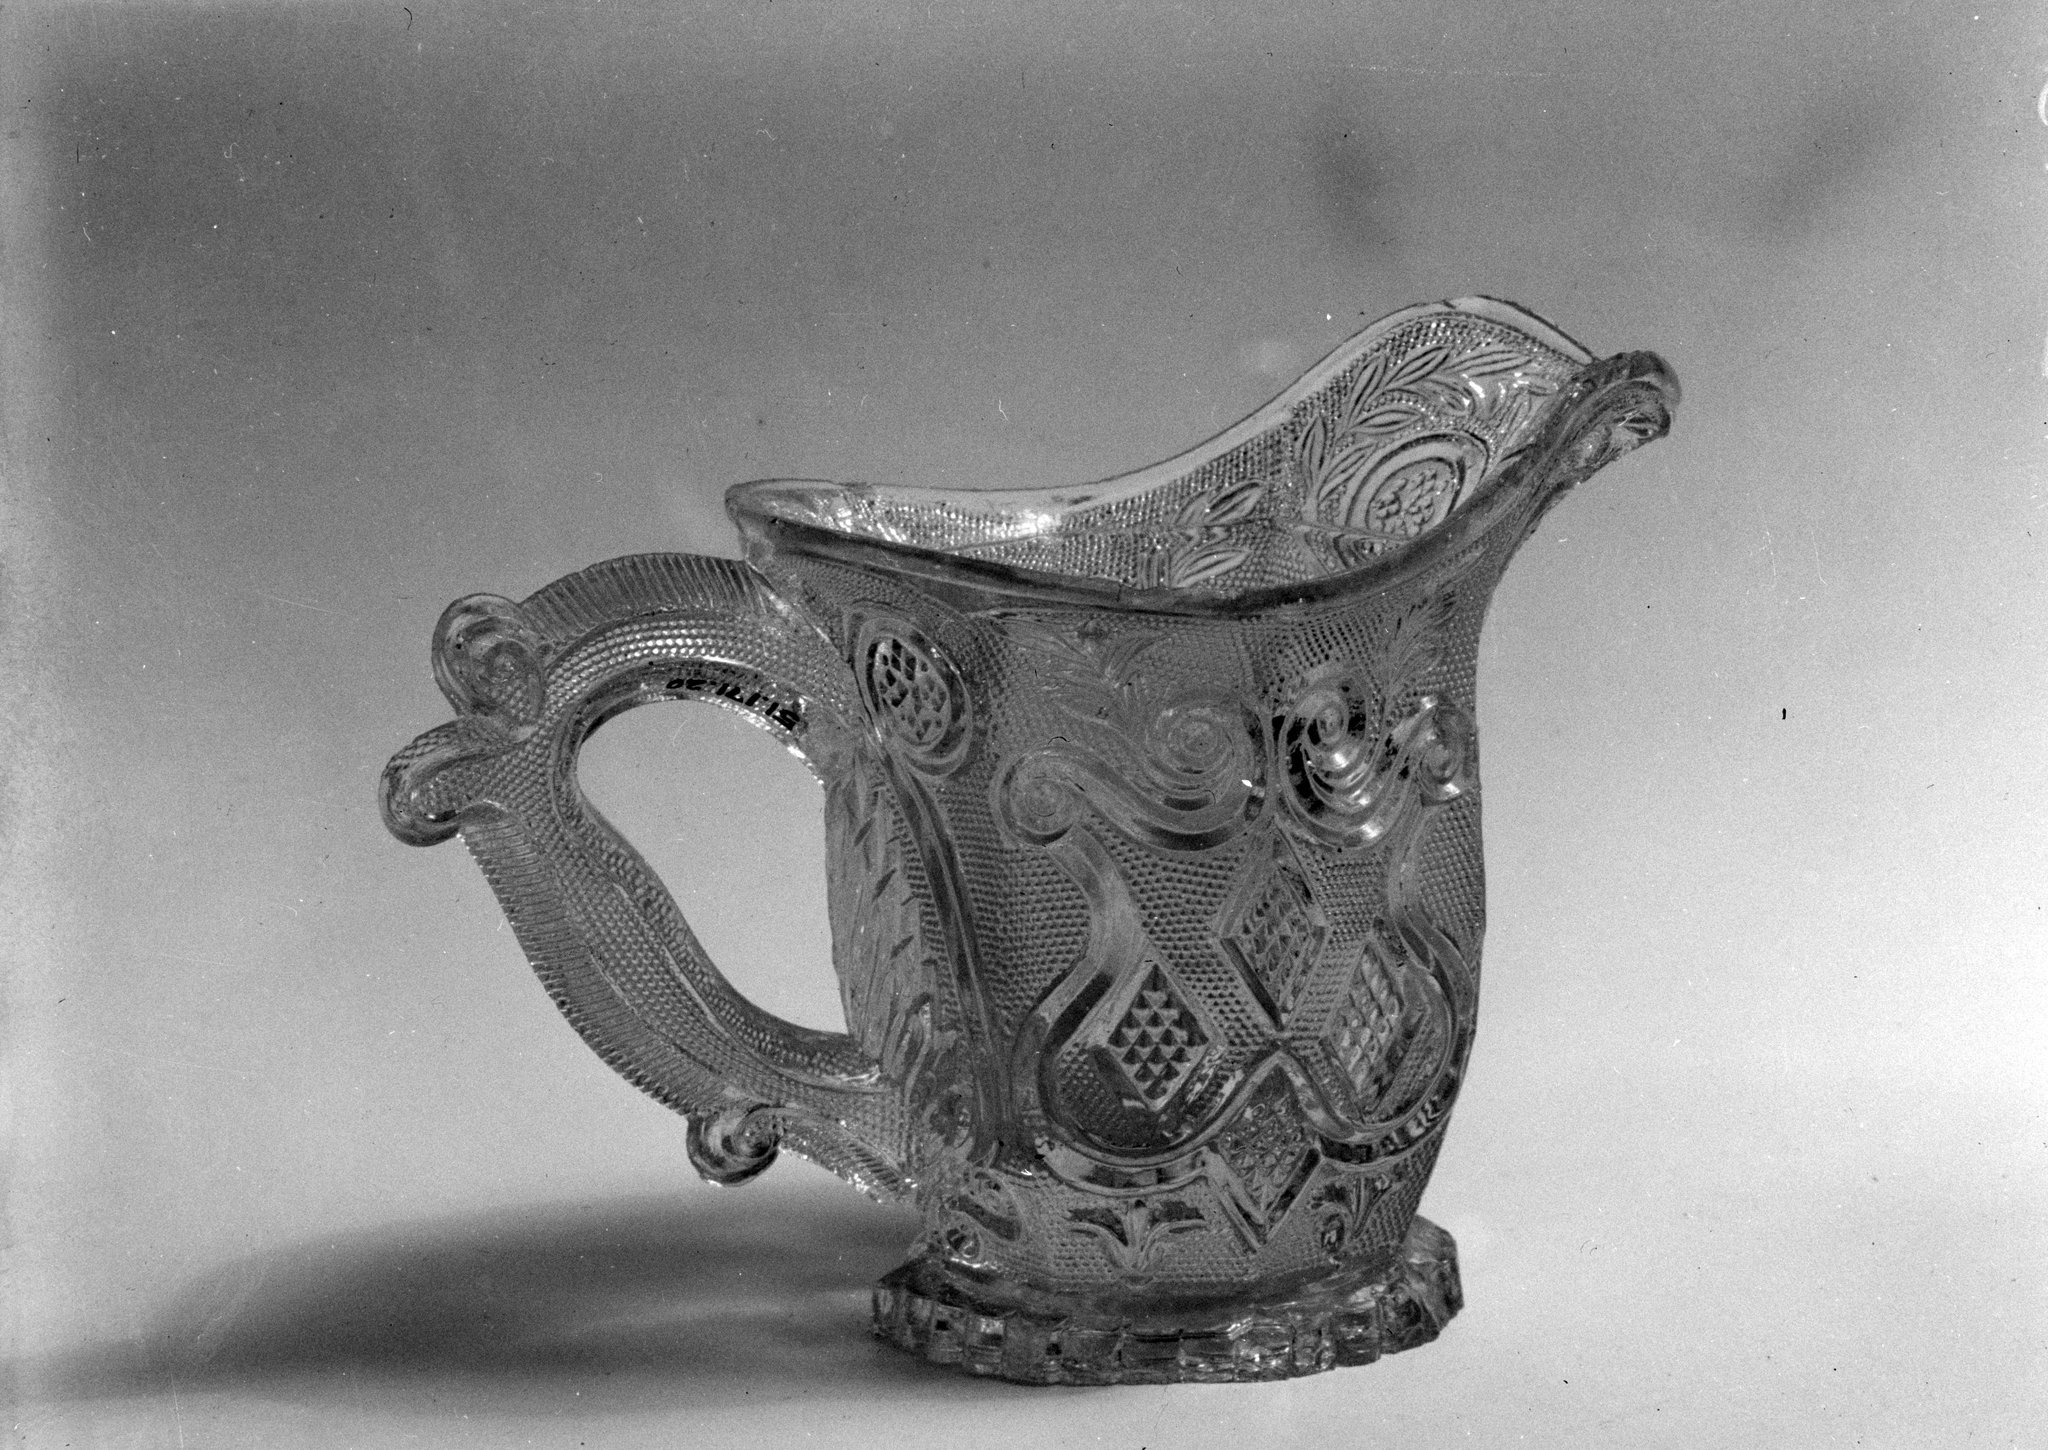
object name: cream pot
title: Creamer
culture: american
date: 1830-1840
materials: glass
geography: united states